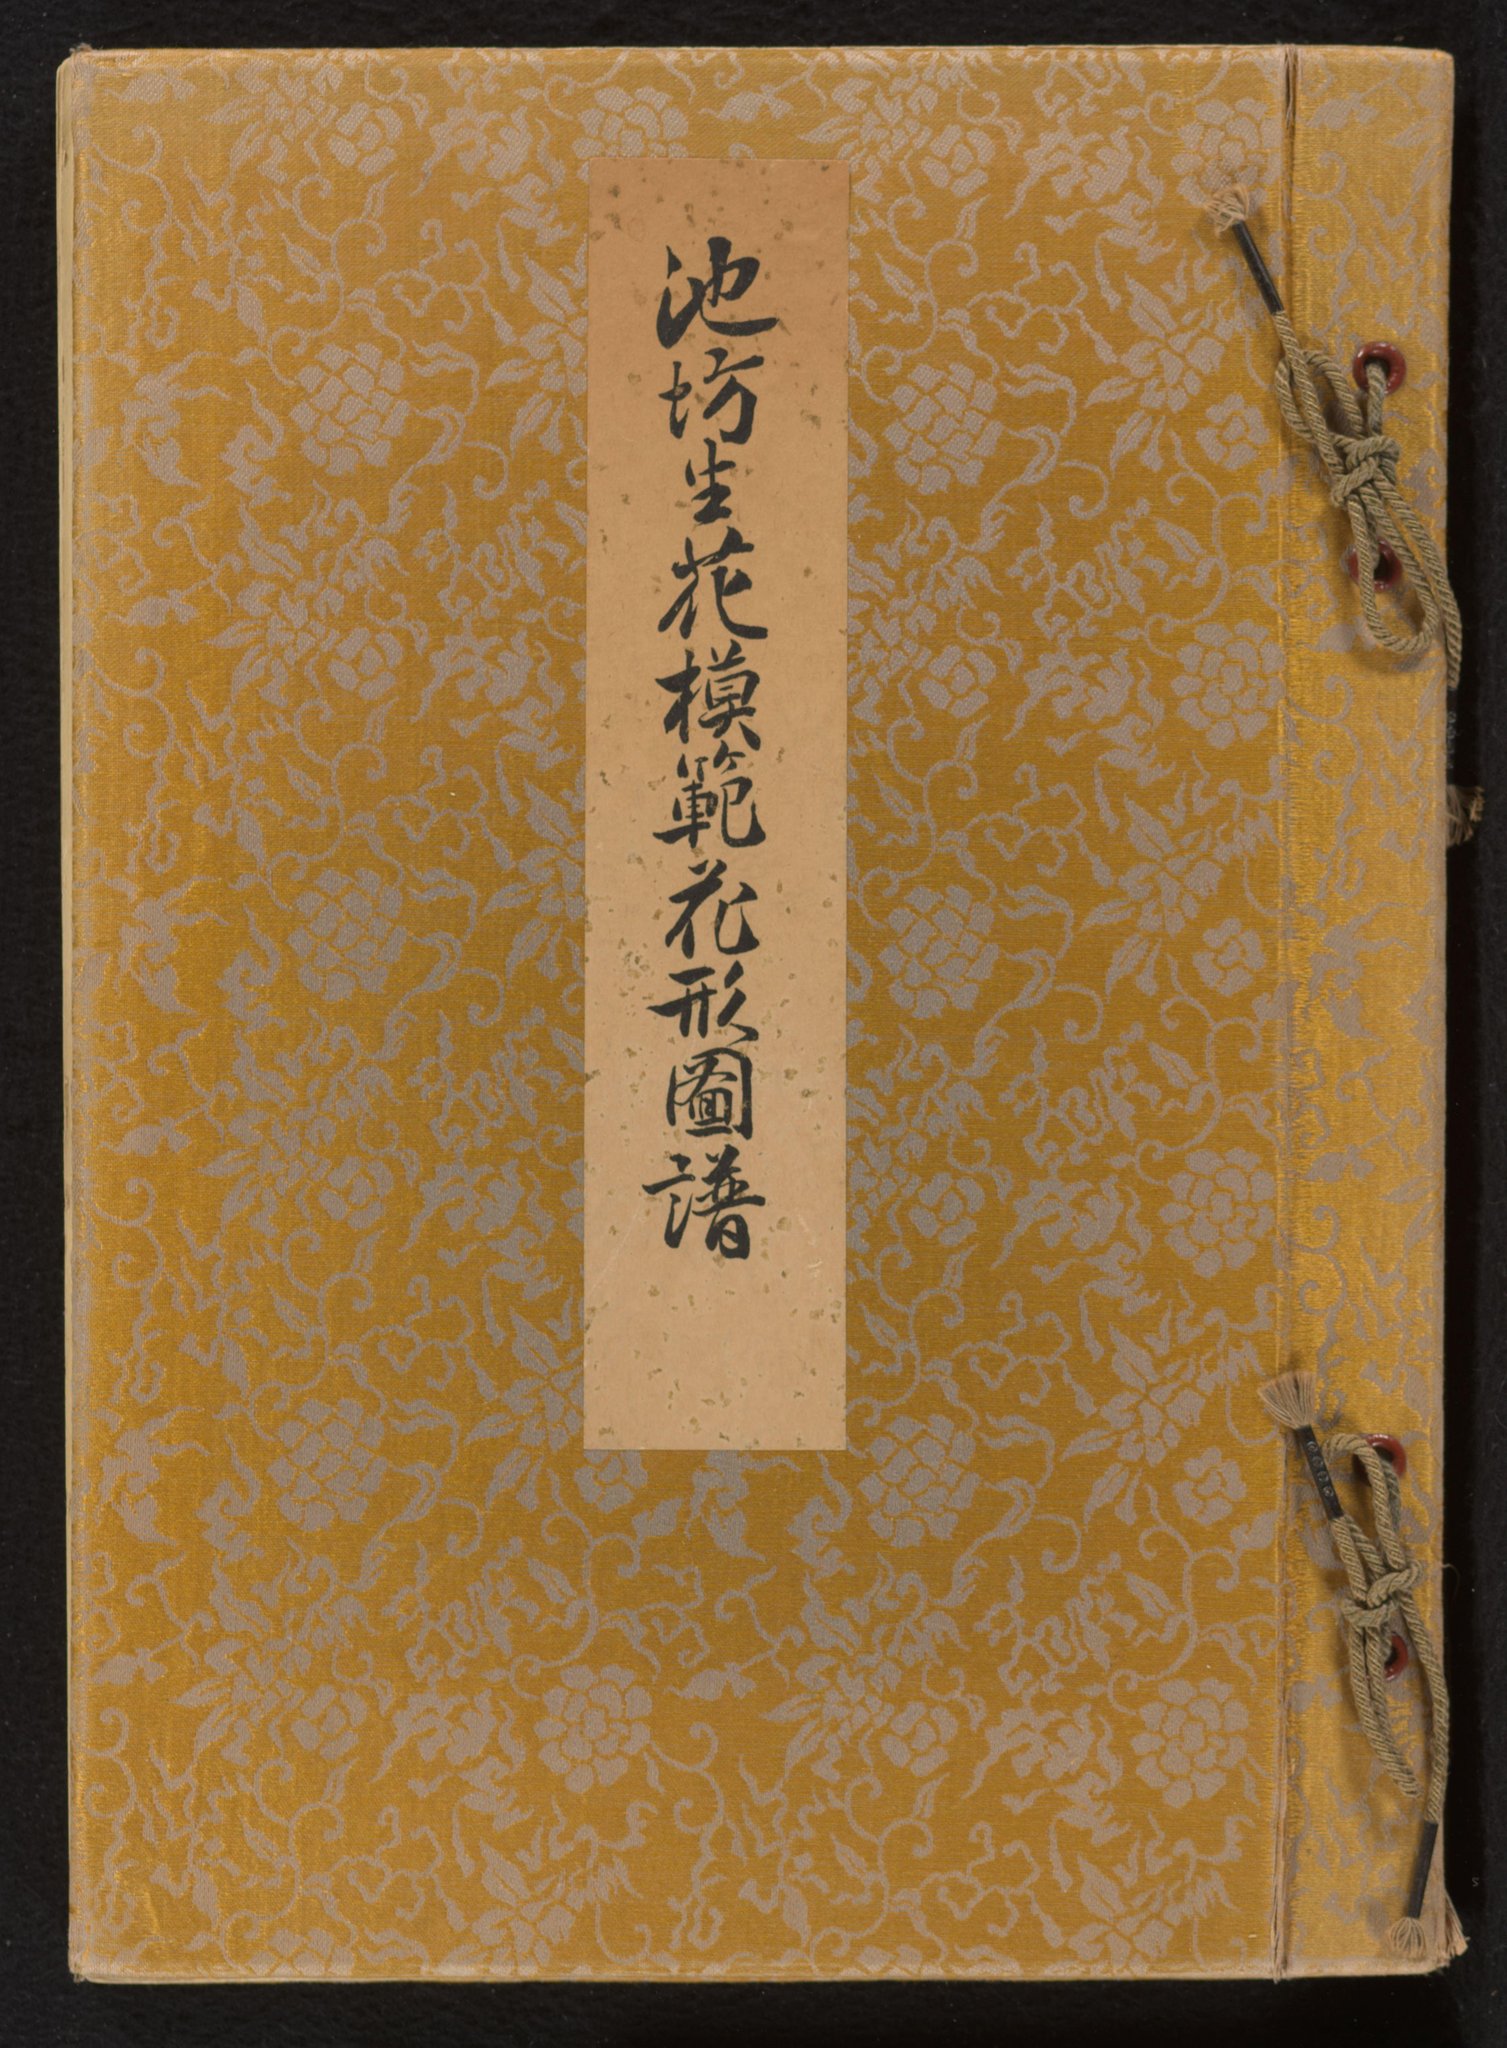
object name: book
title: Ikenobo ikebana mohan hanagata zufu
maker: Anonymous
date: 1936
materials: cardboard, paper, fiber, silk, textile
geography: japan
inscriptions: number: ‘5439-12’